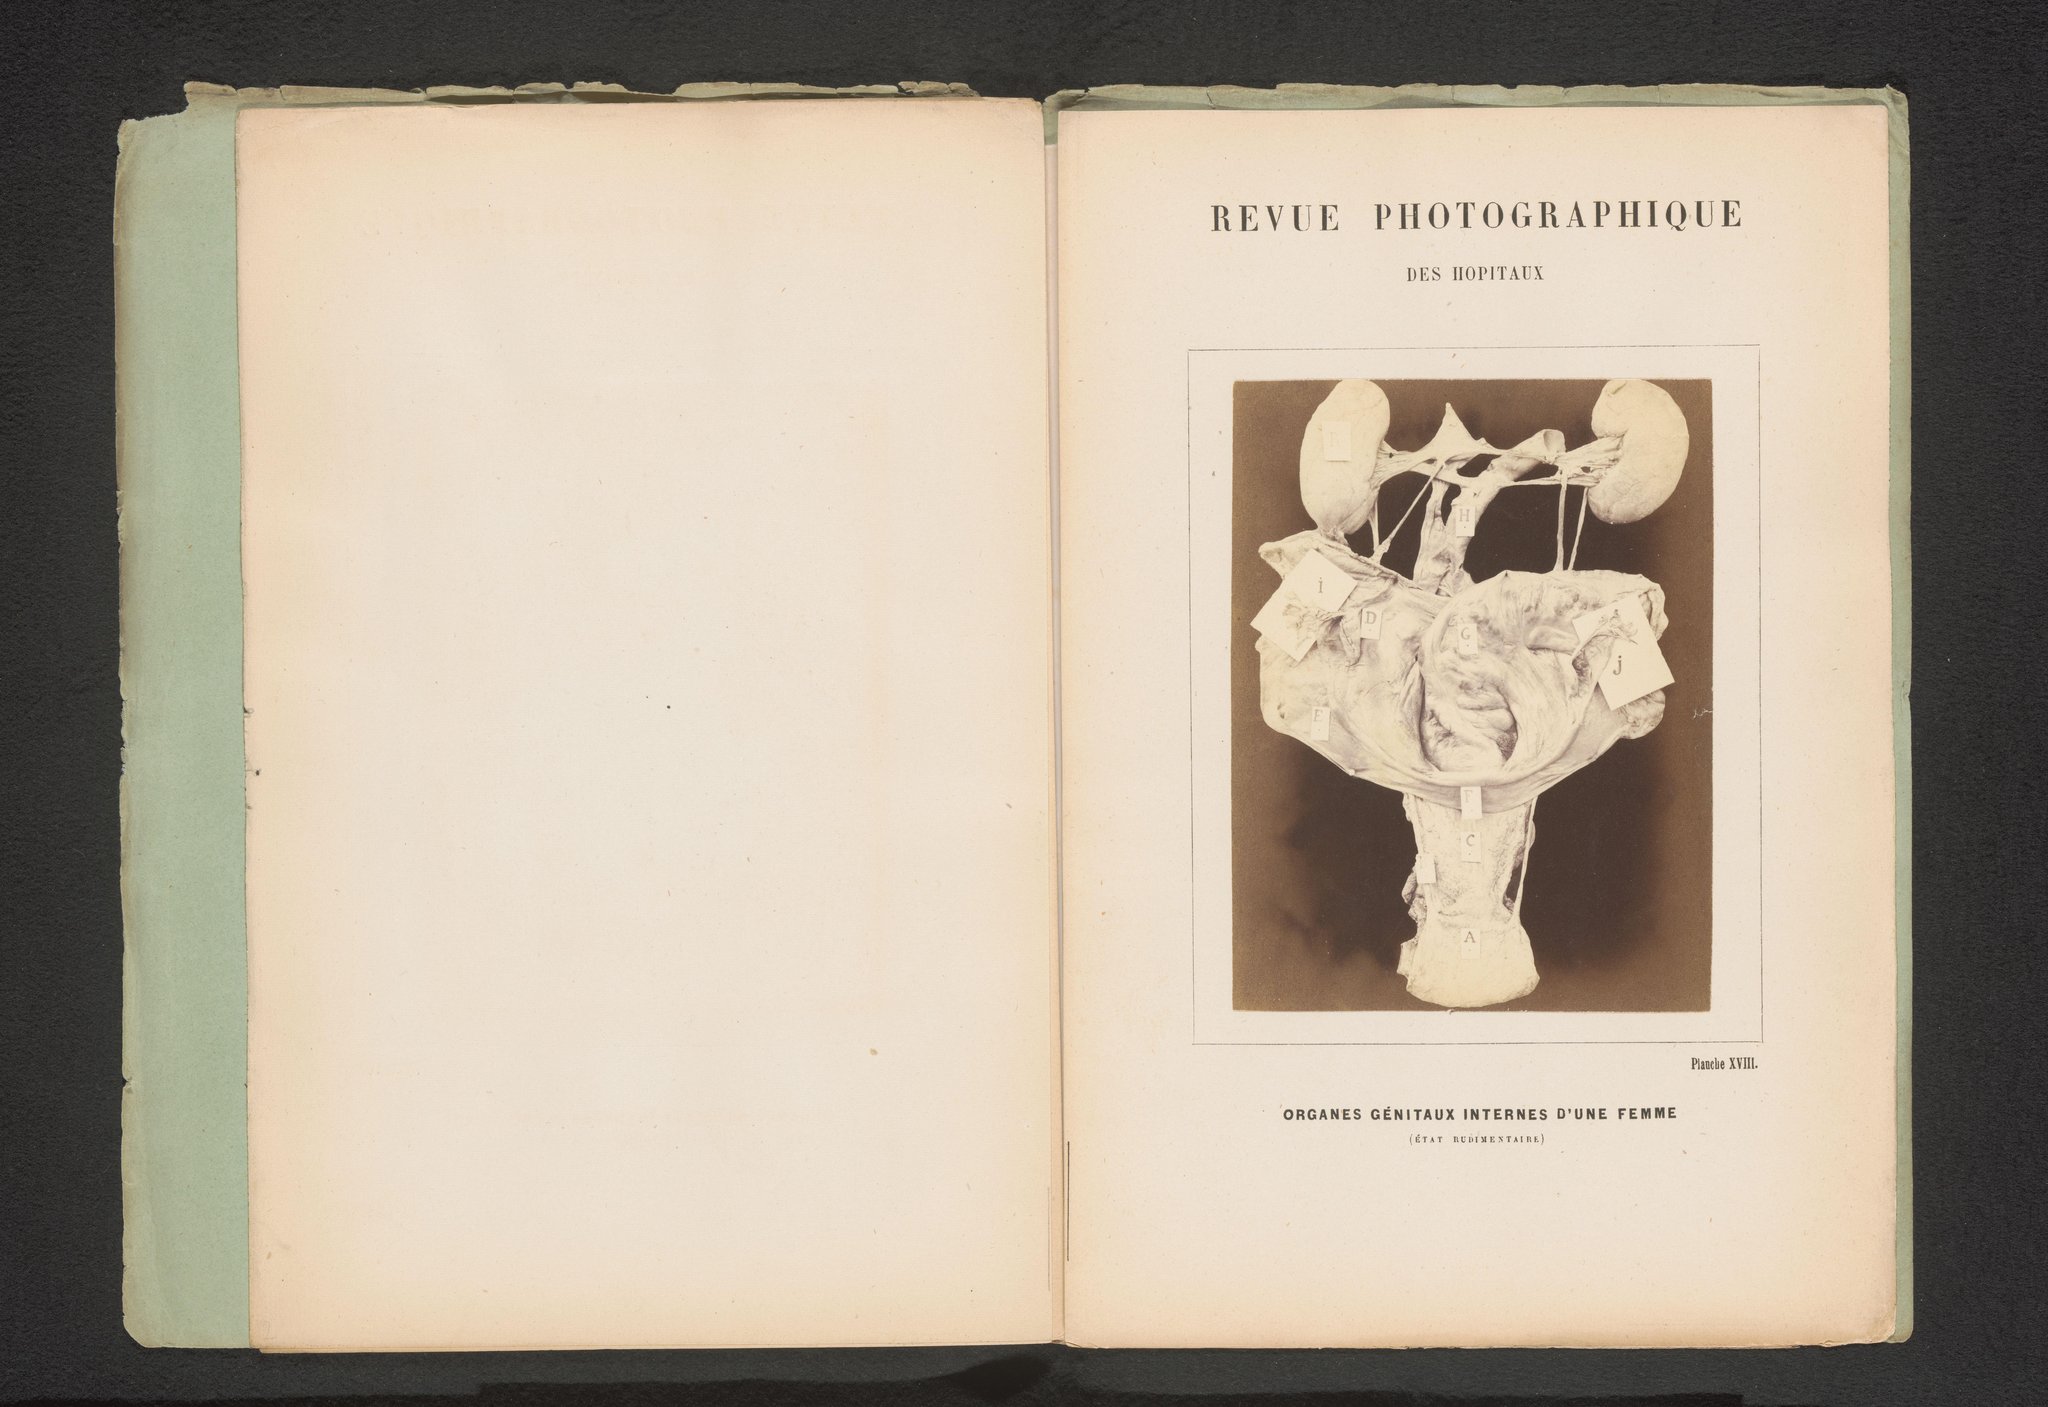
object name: page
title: Organes génitaux internes d'une femme - état rudimentaire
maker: Anonymous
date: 1865-1870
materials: paper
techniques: albumen print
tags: female sexual organs, medical research, branches of medicine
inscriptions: inscription: ‘Revue photographique/ des hopitaux/ Planche XVIII.’